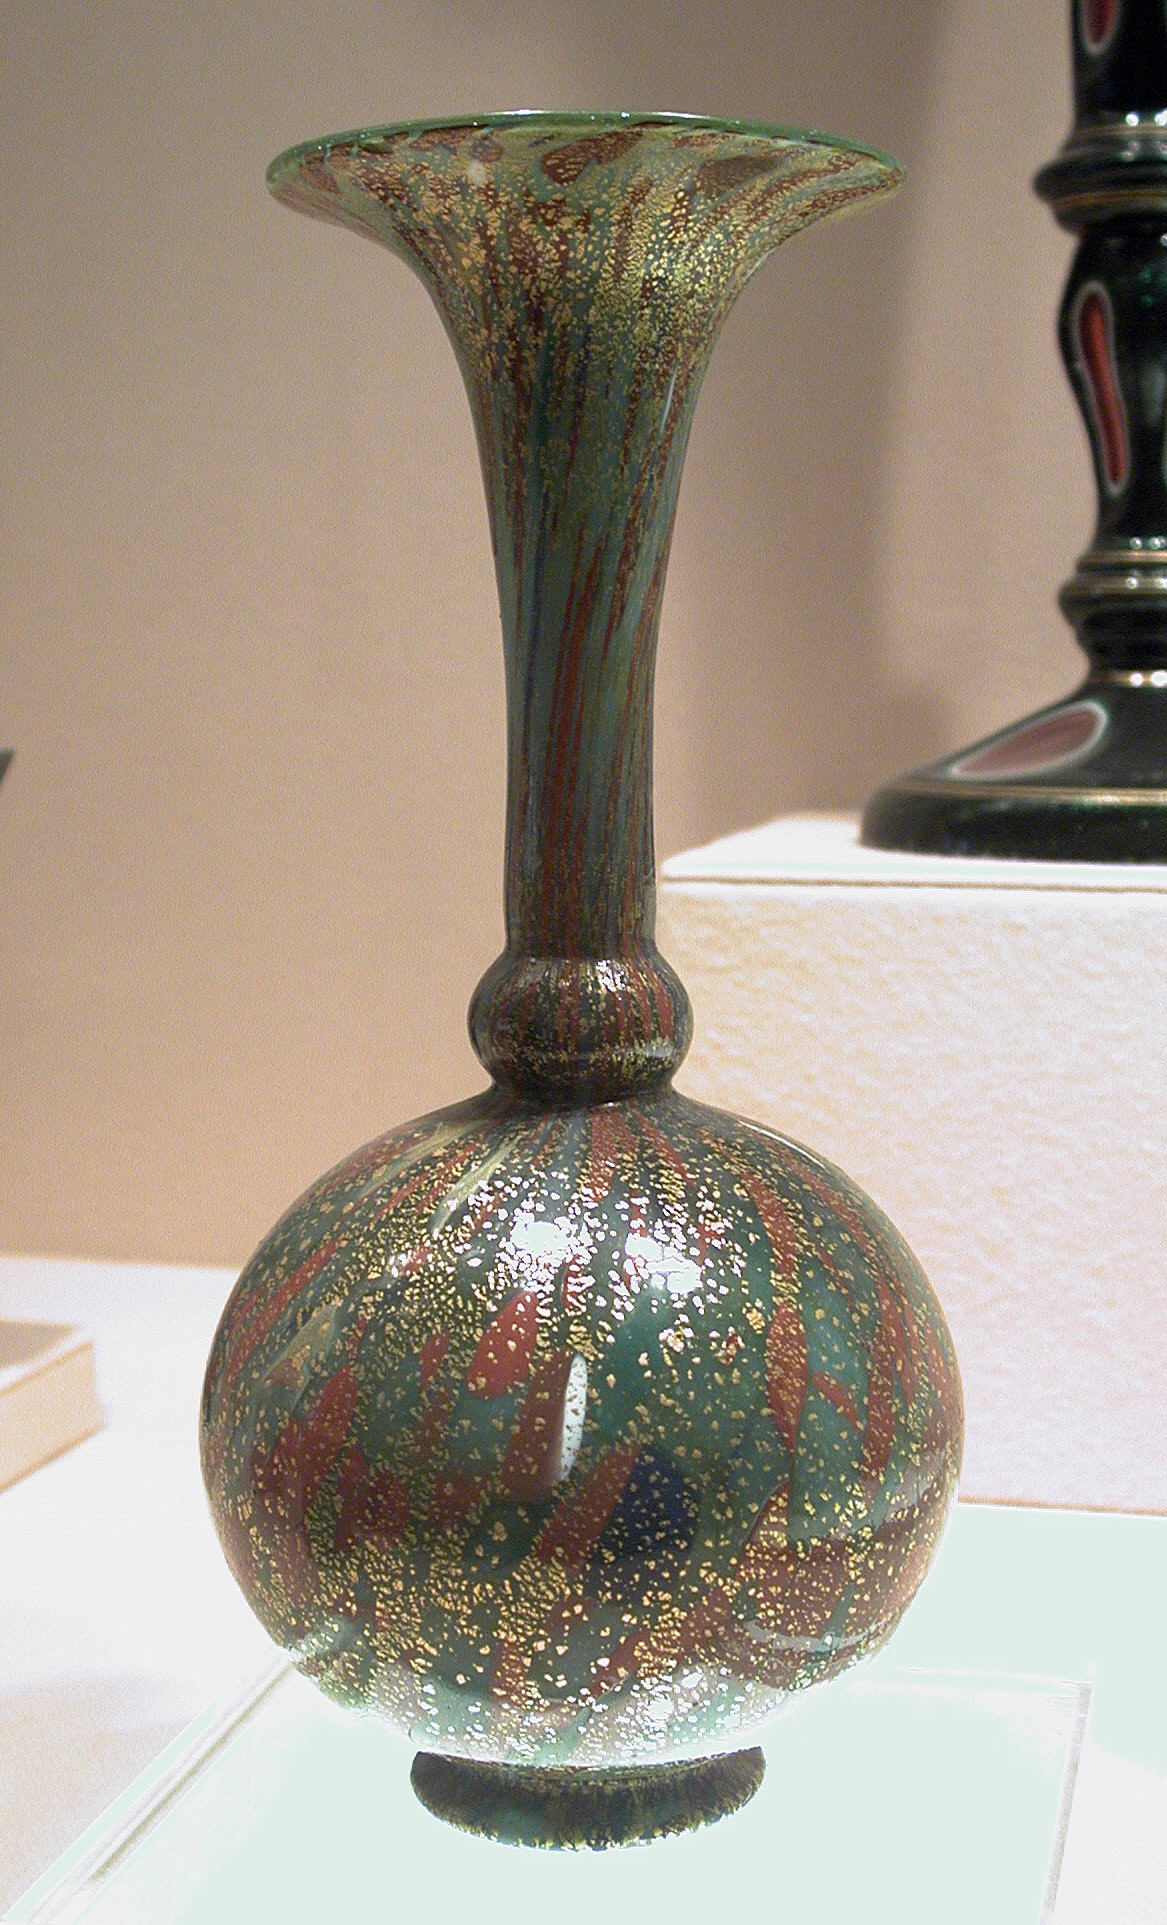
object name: vase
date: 1801-1900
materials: glass